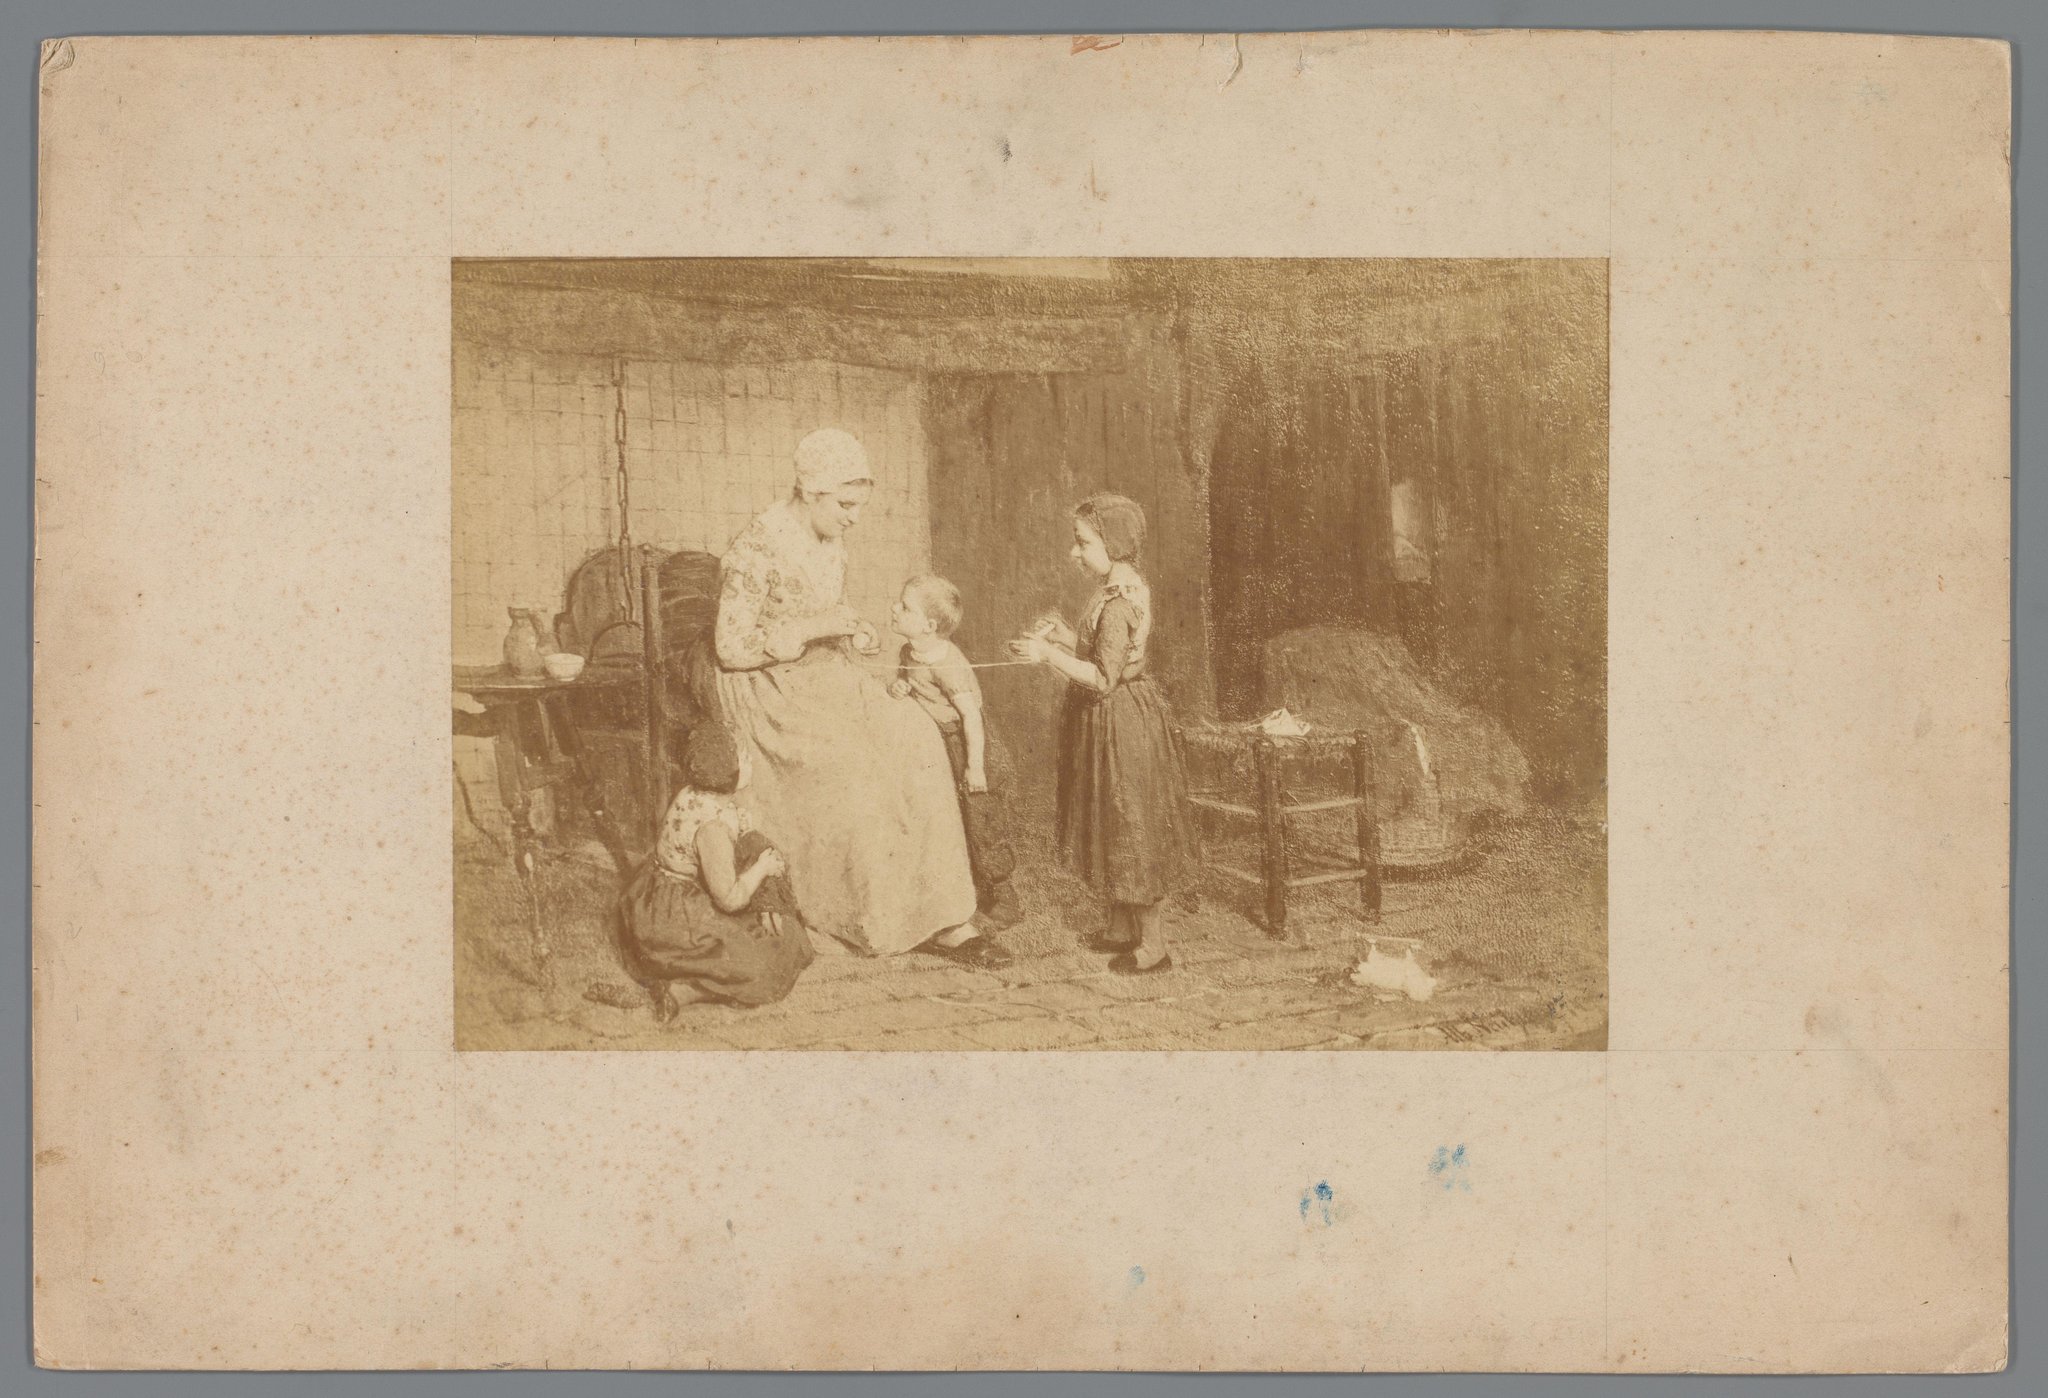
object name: photograph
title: Schilderij van Albert Neuhuys met daarop een vrouw met drie kinderen in een huiskamer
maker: Anonymous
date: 1880-1914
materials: paper, photographic support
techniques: matte daylight collodion silver print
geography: netherlands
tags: utrecht, painter, print maker, draughtsman, albert neuhuys (1844-1914)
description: De vrouw rolt samen met een van de kinderen een bol wol op